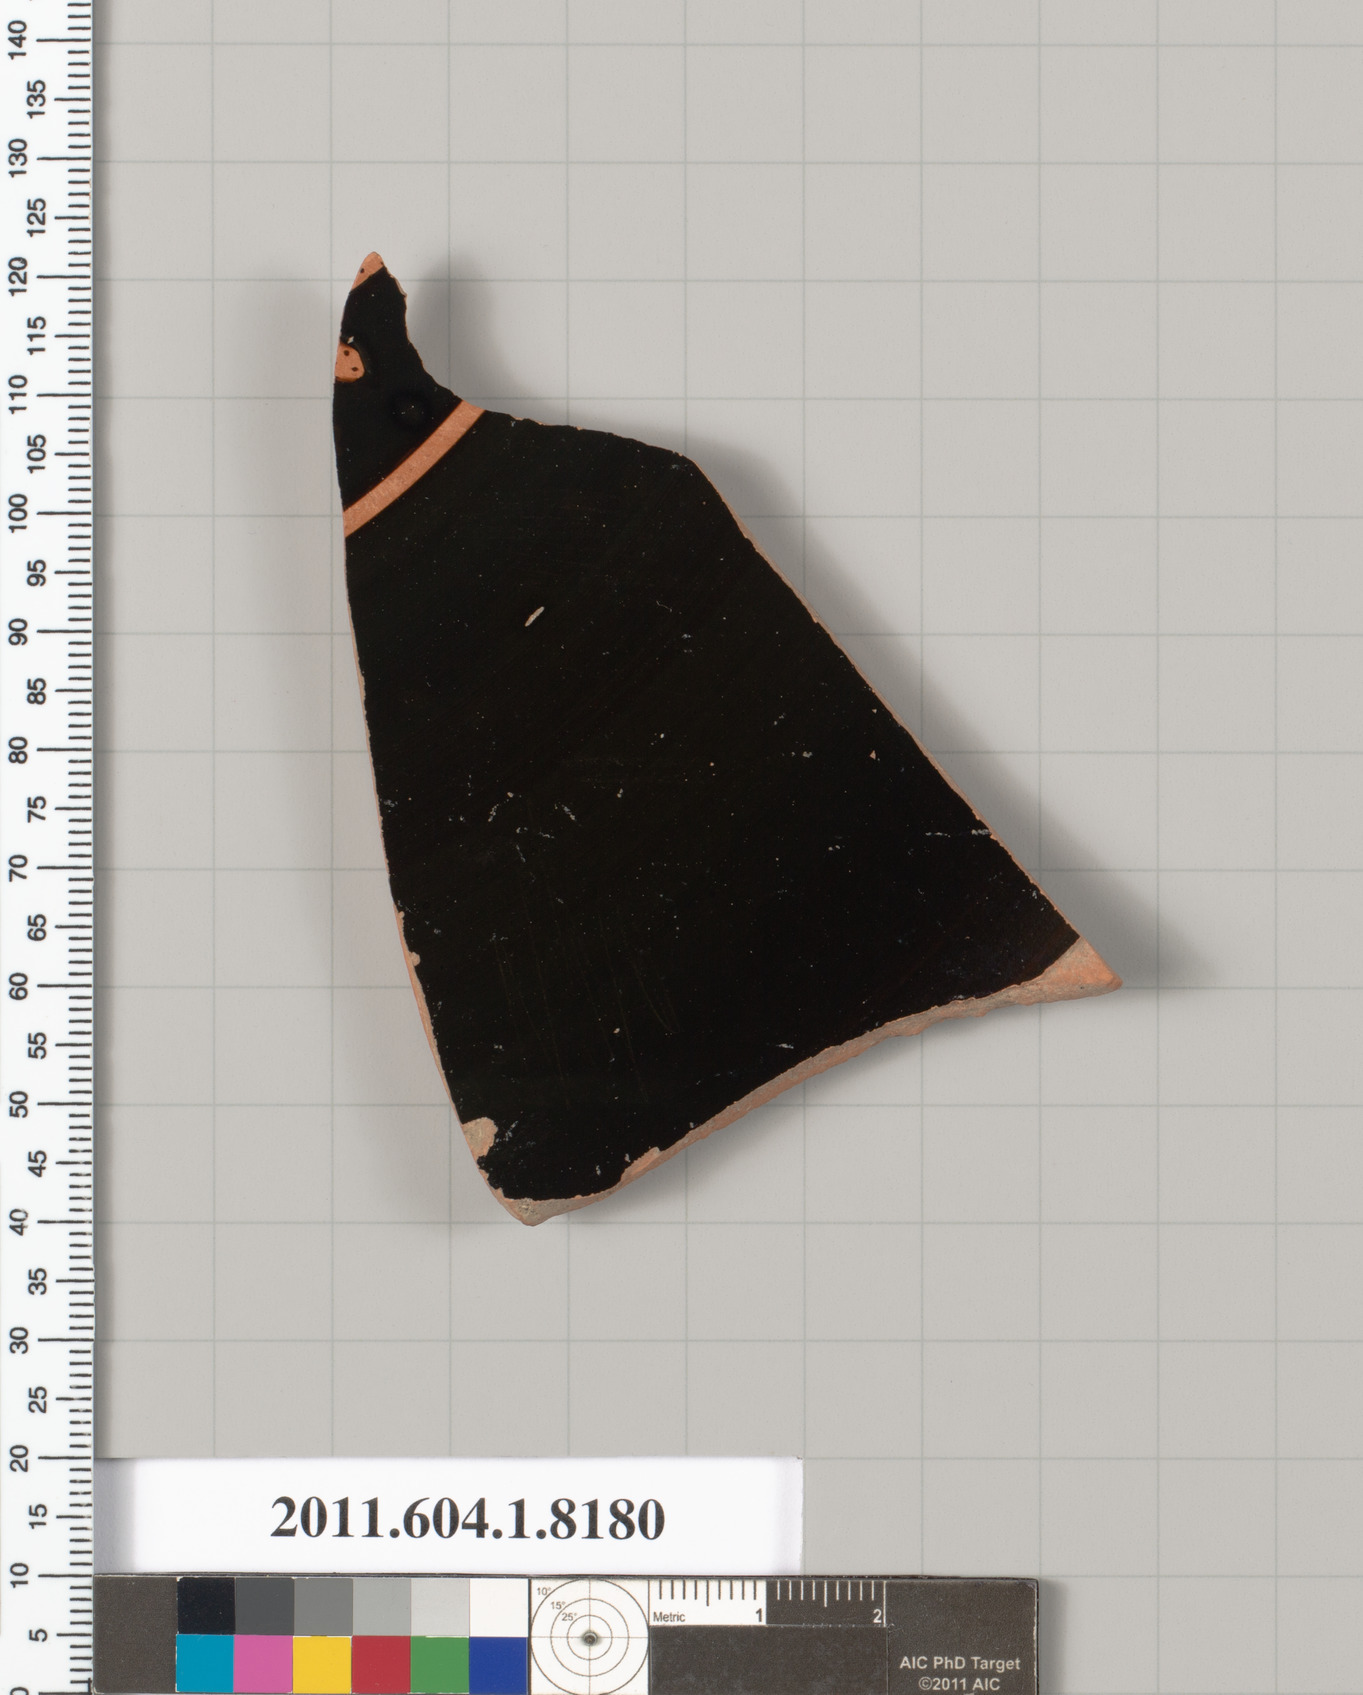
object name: kylix fragment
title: Terracotta fragment of a kylix (drinking cup)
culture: greek, attic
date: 520-510 BCE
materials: terracotta